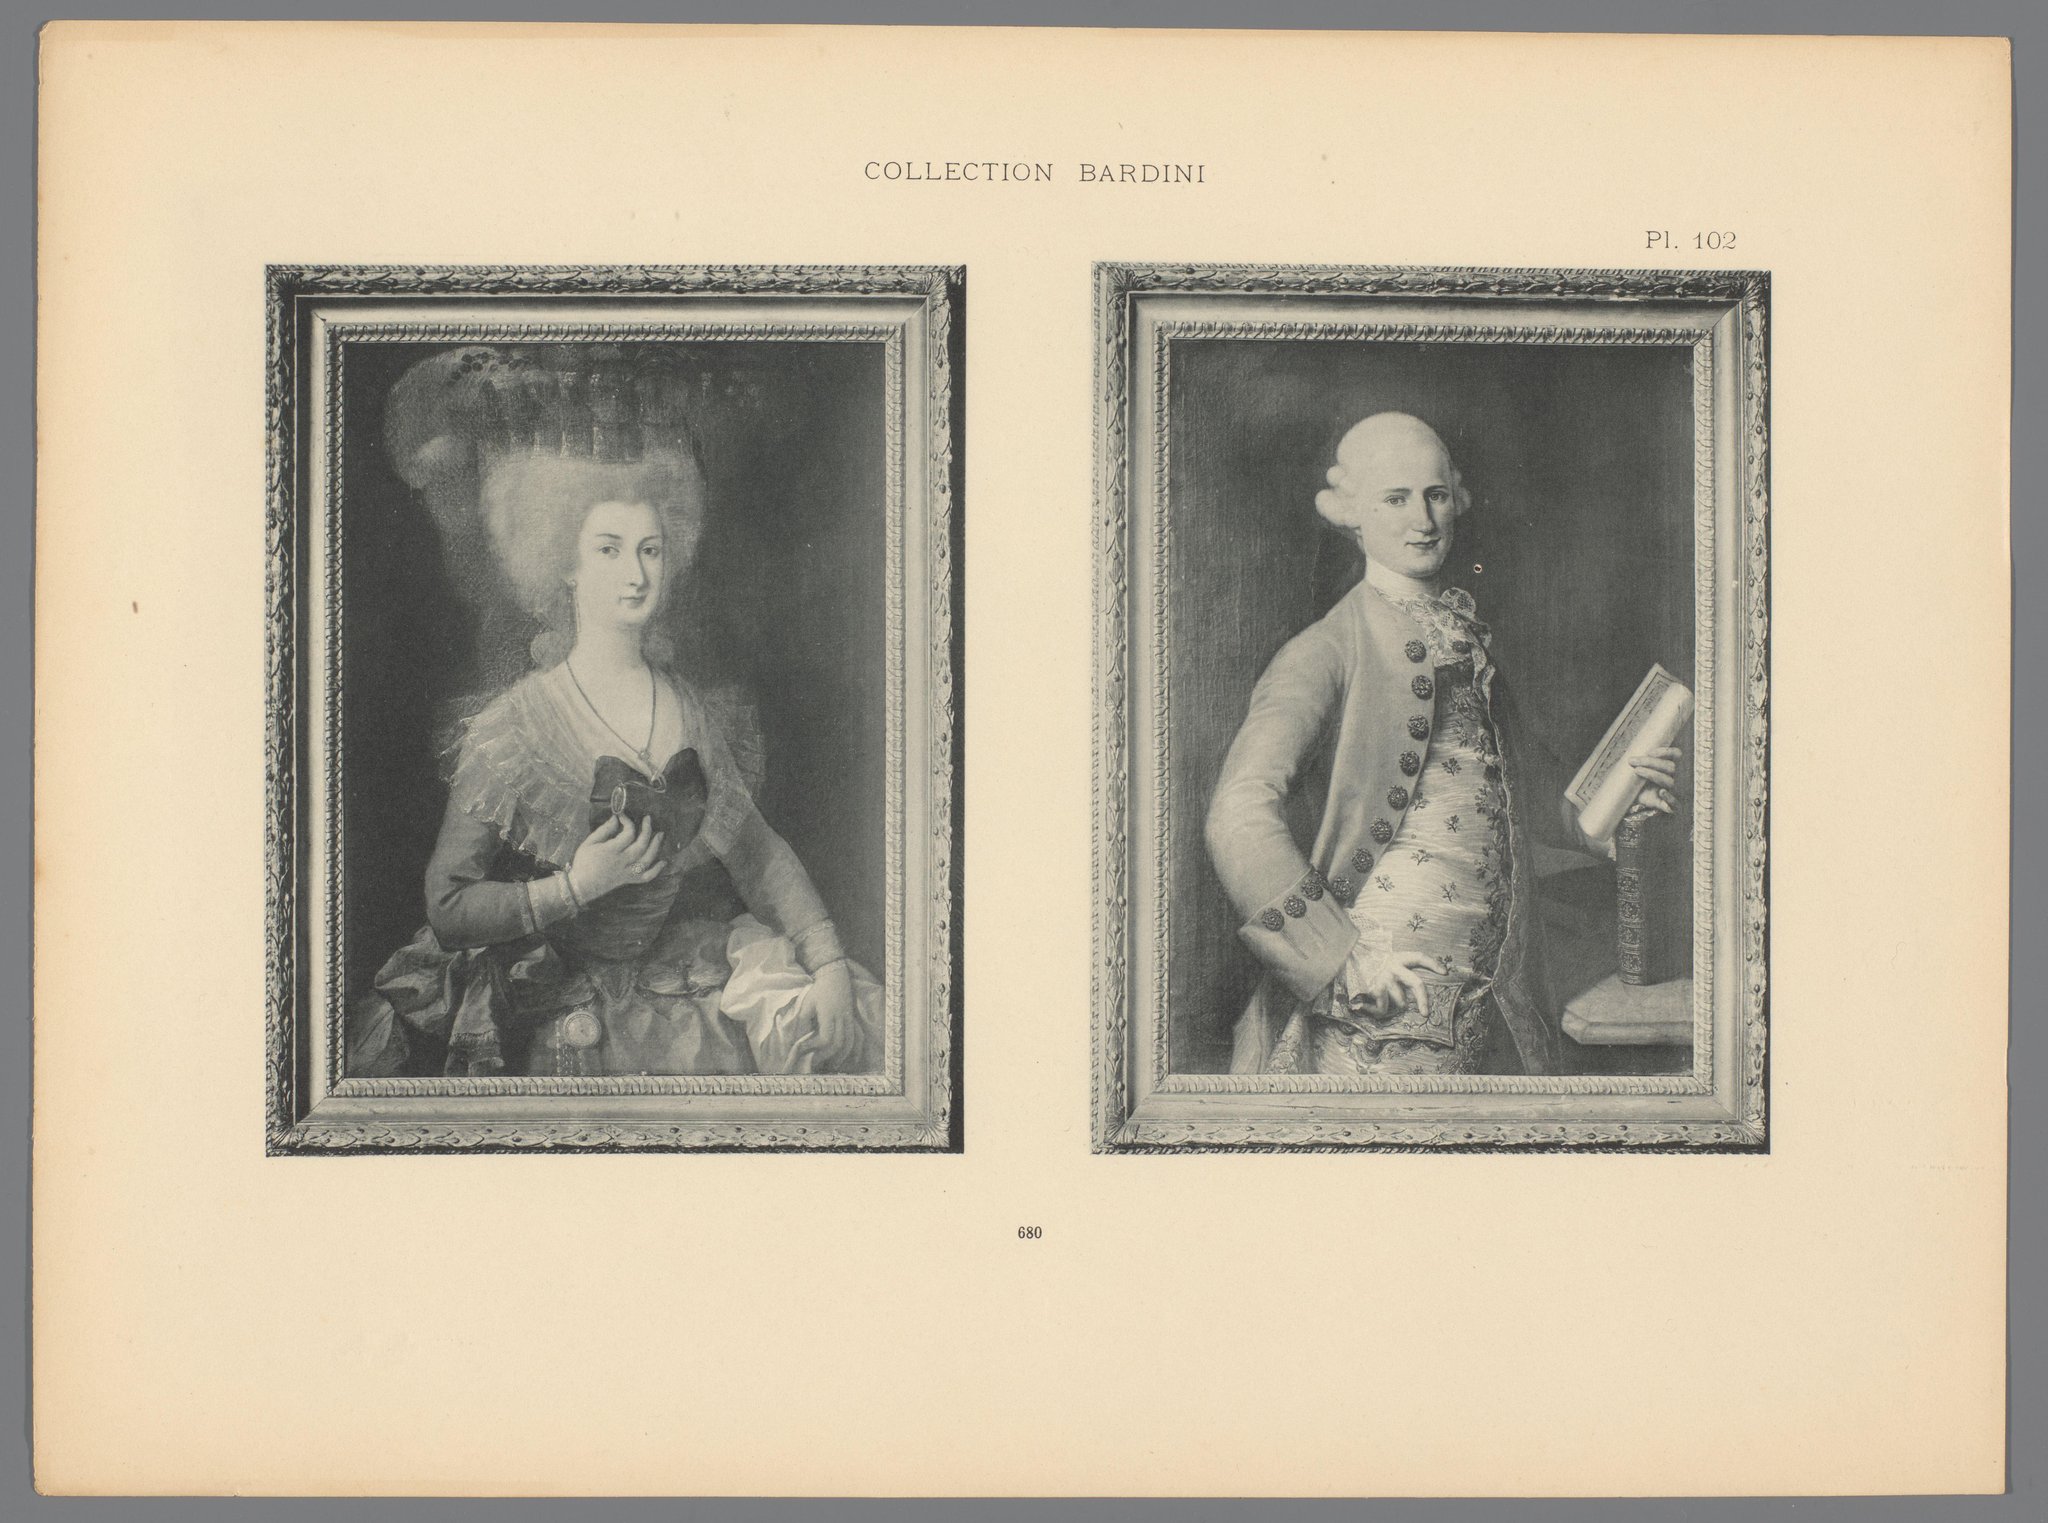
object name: photomechanical print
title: Tweetal schilderijen in lijst, een portret van een onbekende vrouw en een portret van een onbekende man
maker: Anonymous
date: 1875-1930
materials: paper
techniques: photograph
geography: florence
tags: anonymous historical person portrayed, picture, painting, anonymous historical person portrayed - bb - woman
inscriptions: number: ‘Pl. 102’